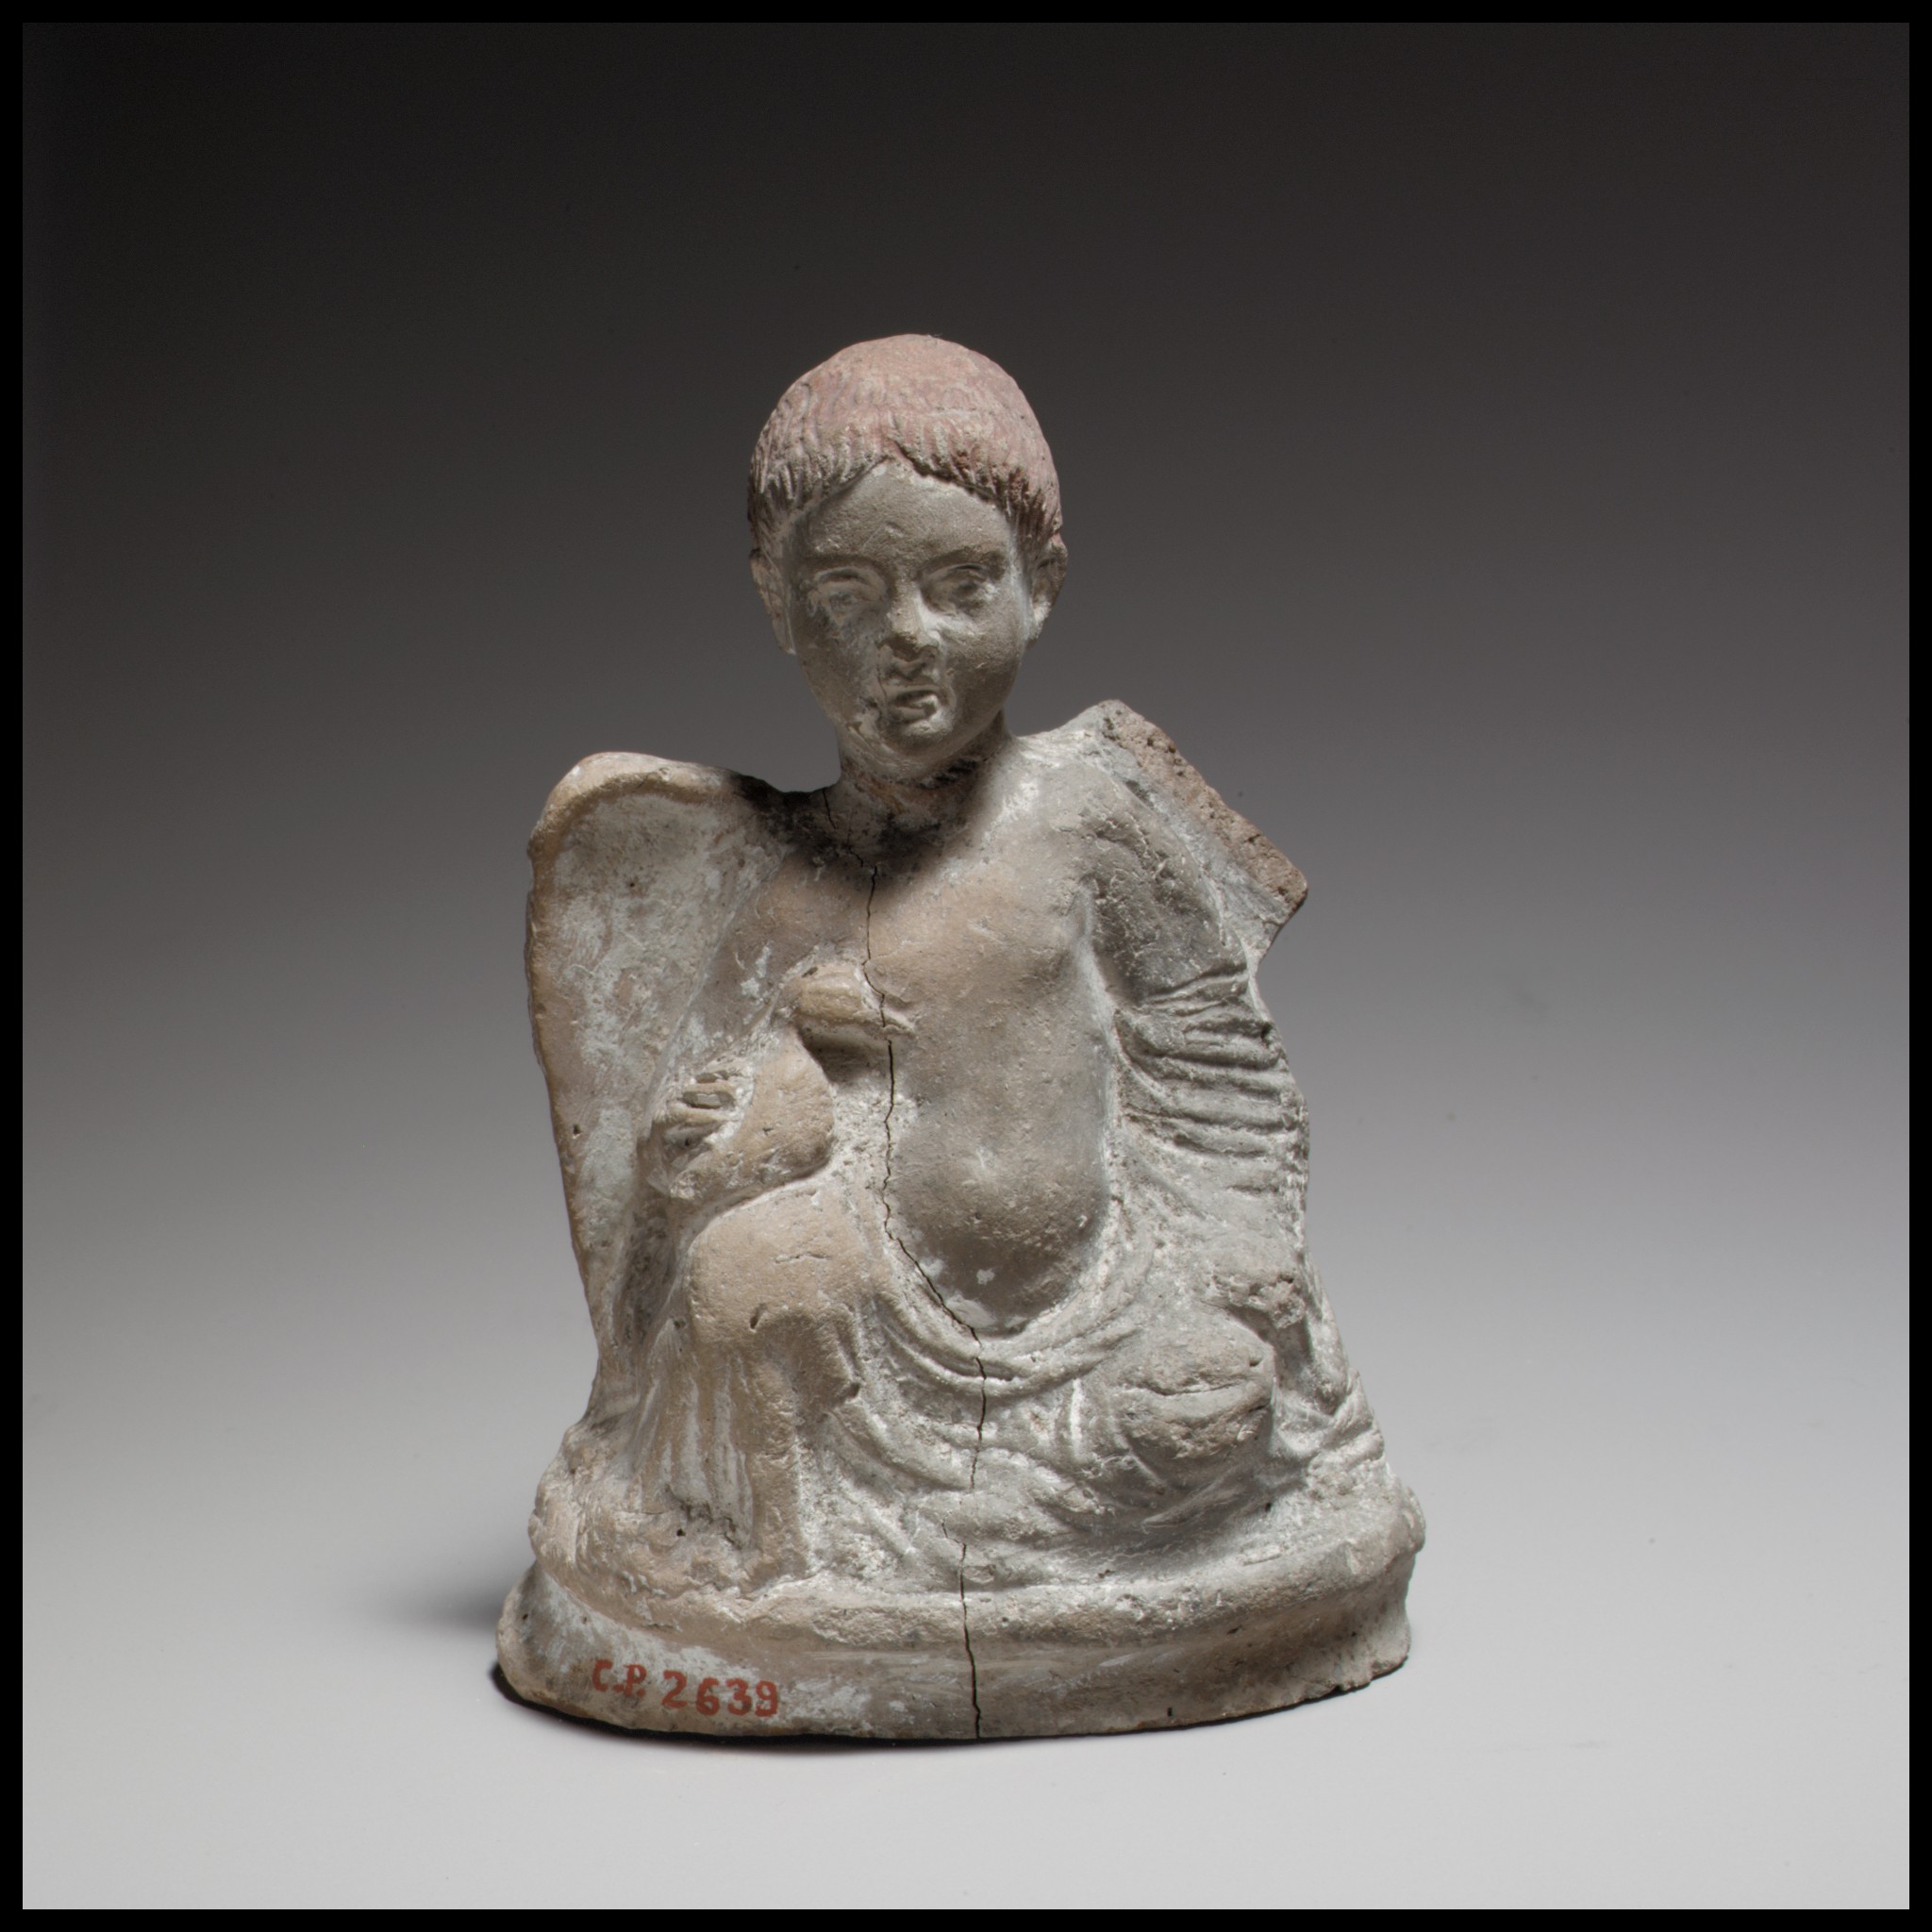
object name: statuette of eros holding duck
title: Terracotta statuette of Eros seated and holding a duck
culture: cypriot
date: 300-201 BCE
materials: terracotta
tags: ducks,eros